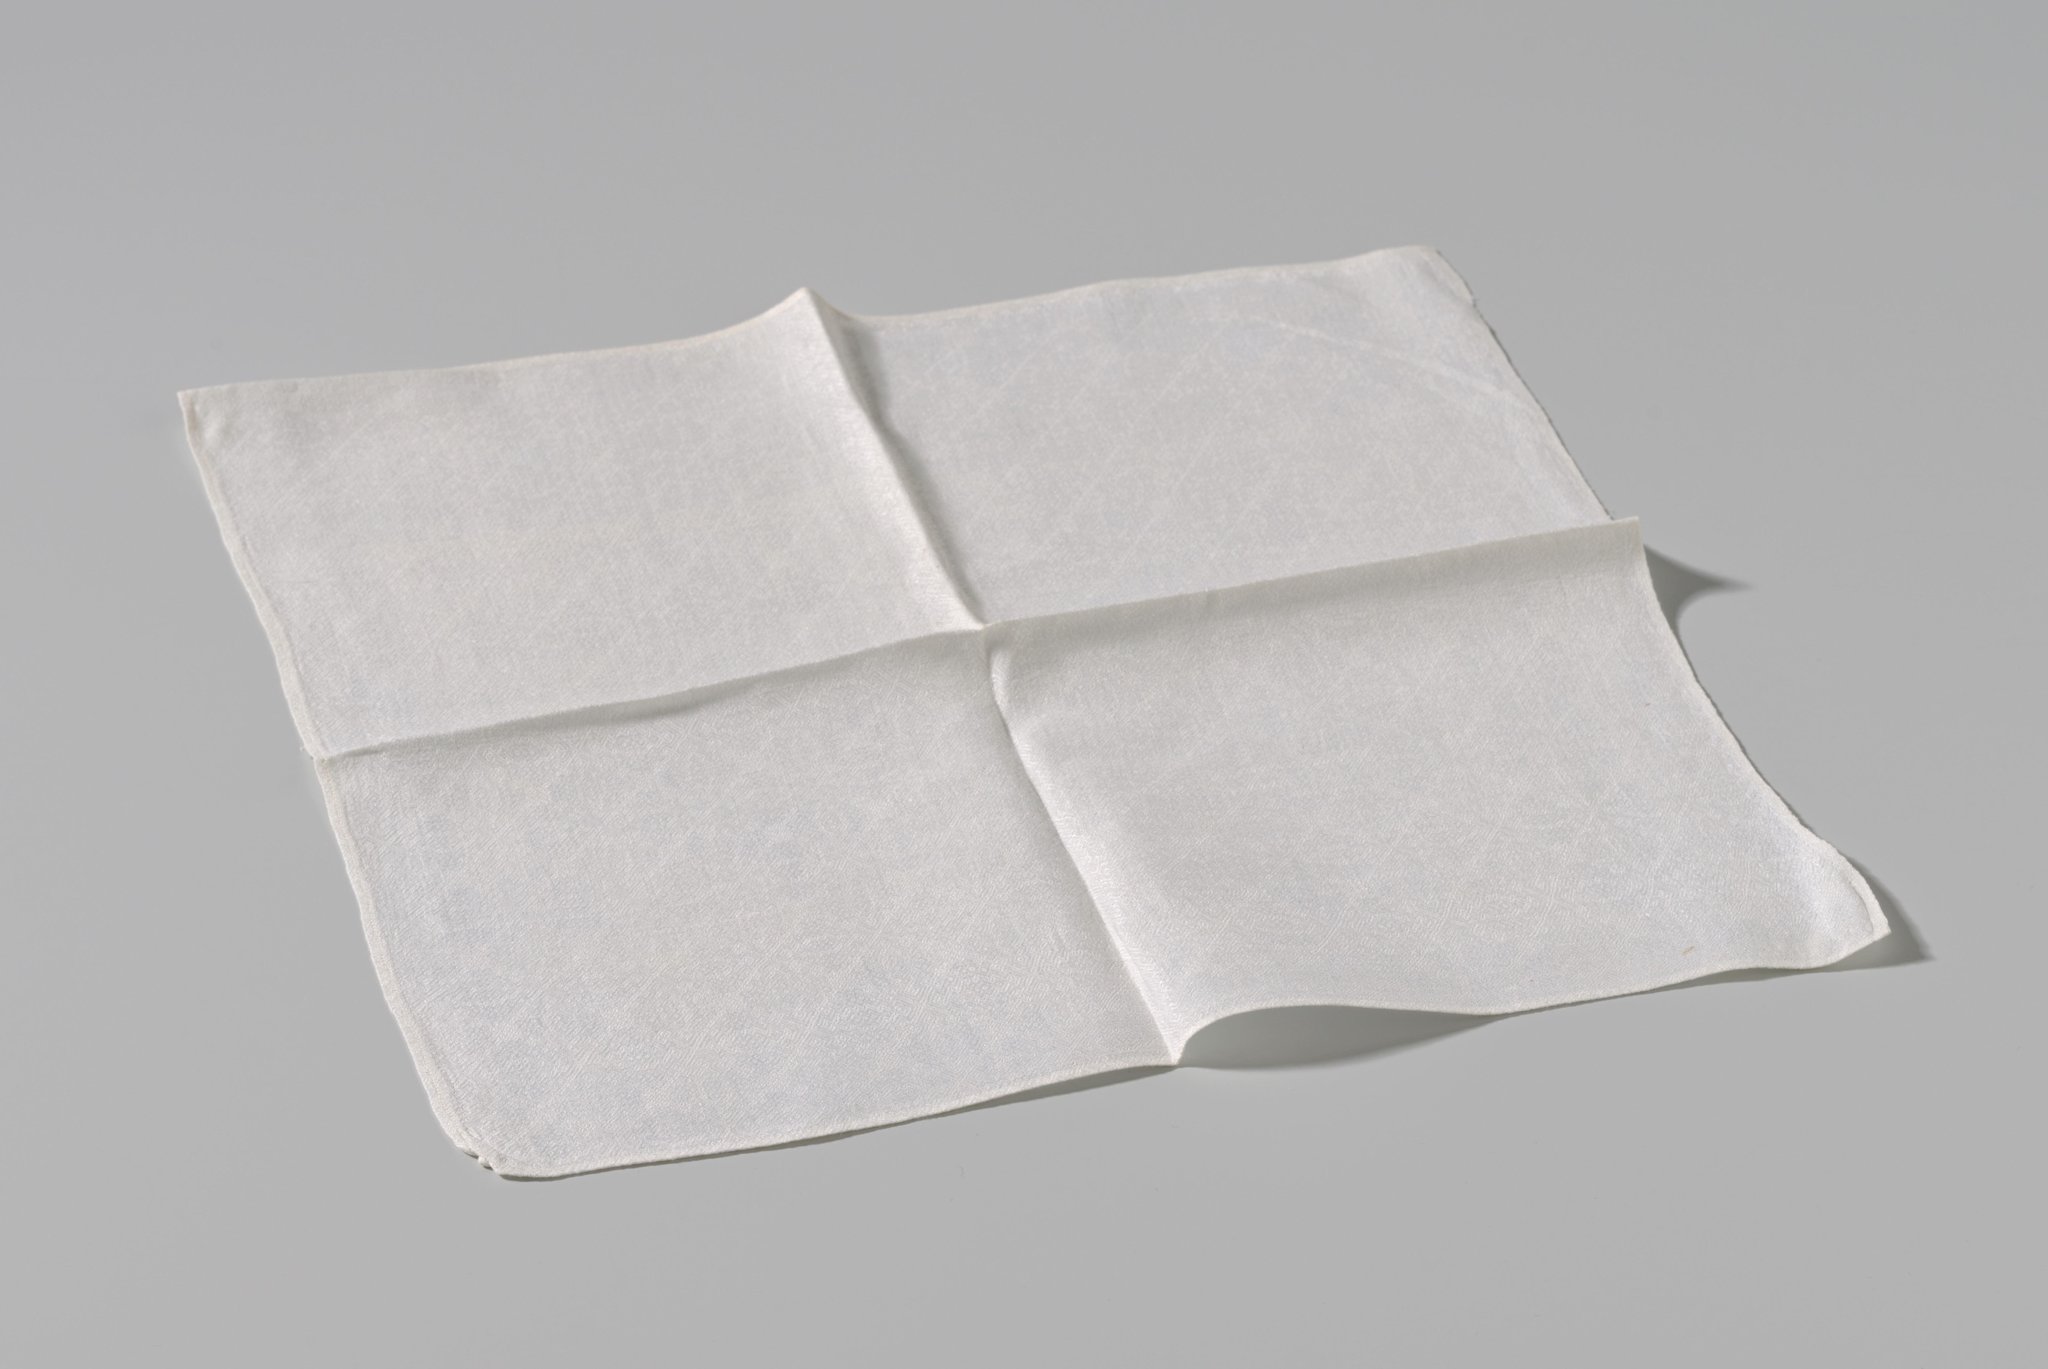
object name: tablecloth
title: Fragment van een servet of tafellaken met kruiswerkpatroon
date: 1600-1650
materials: linen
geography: northern netherlands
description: Fragment van een witlinnen tafellaken of servet met een 'kruiswerk'-patroon.